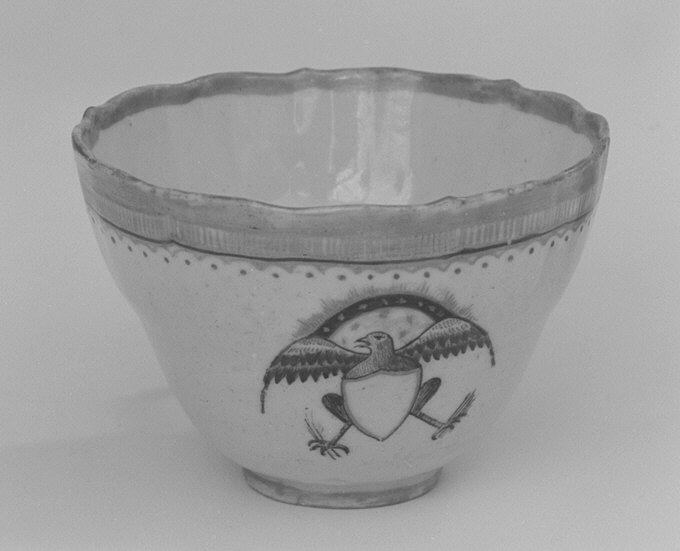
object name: cup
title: Cup (part of a service)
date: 1767-1833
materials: hard paste porcelain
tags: eagles